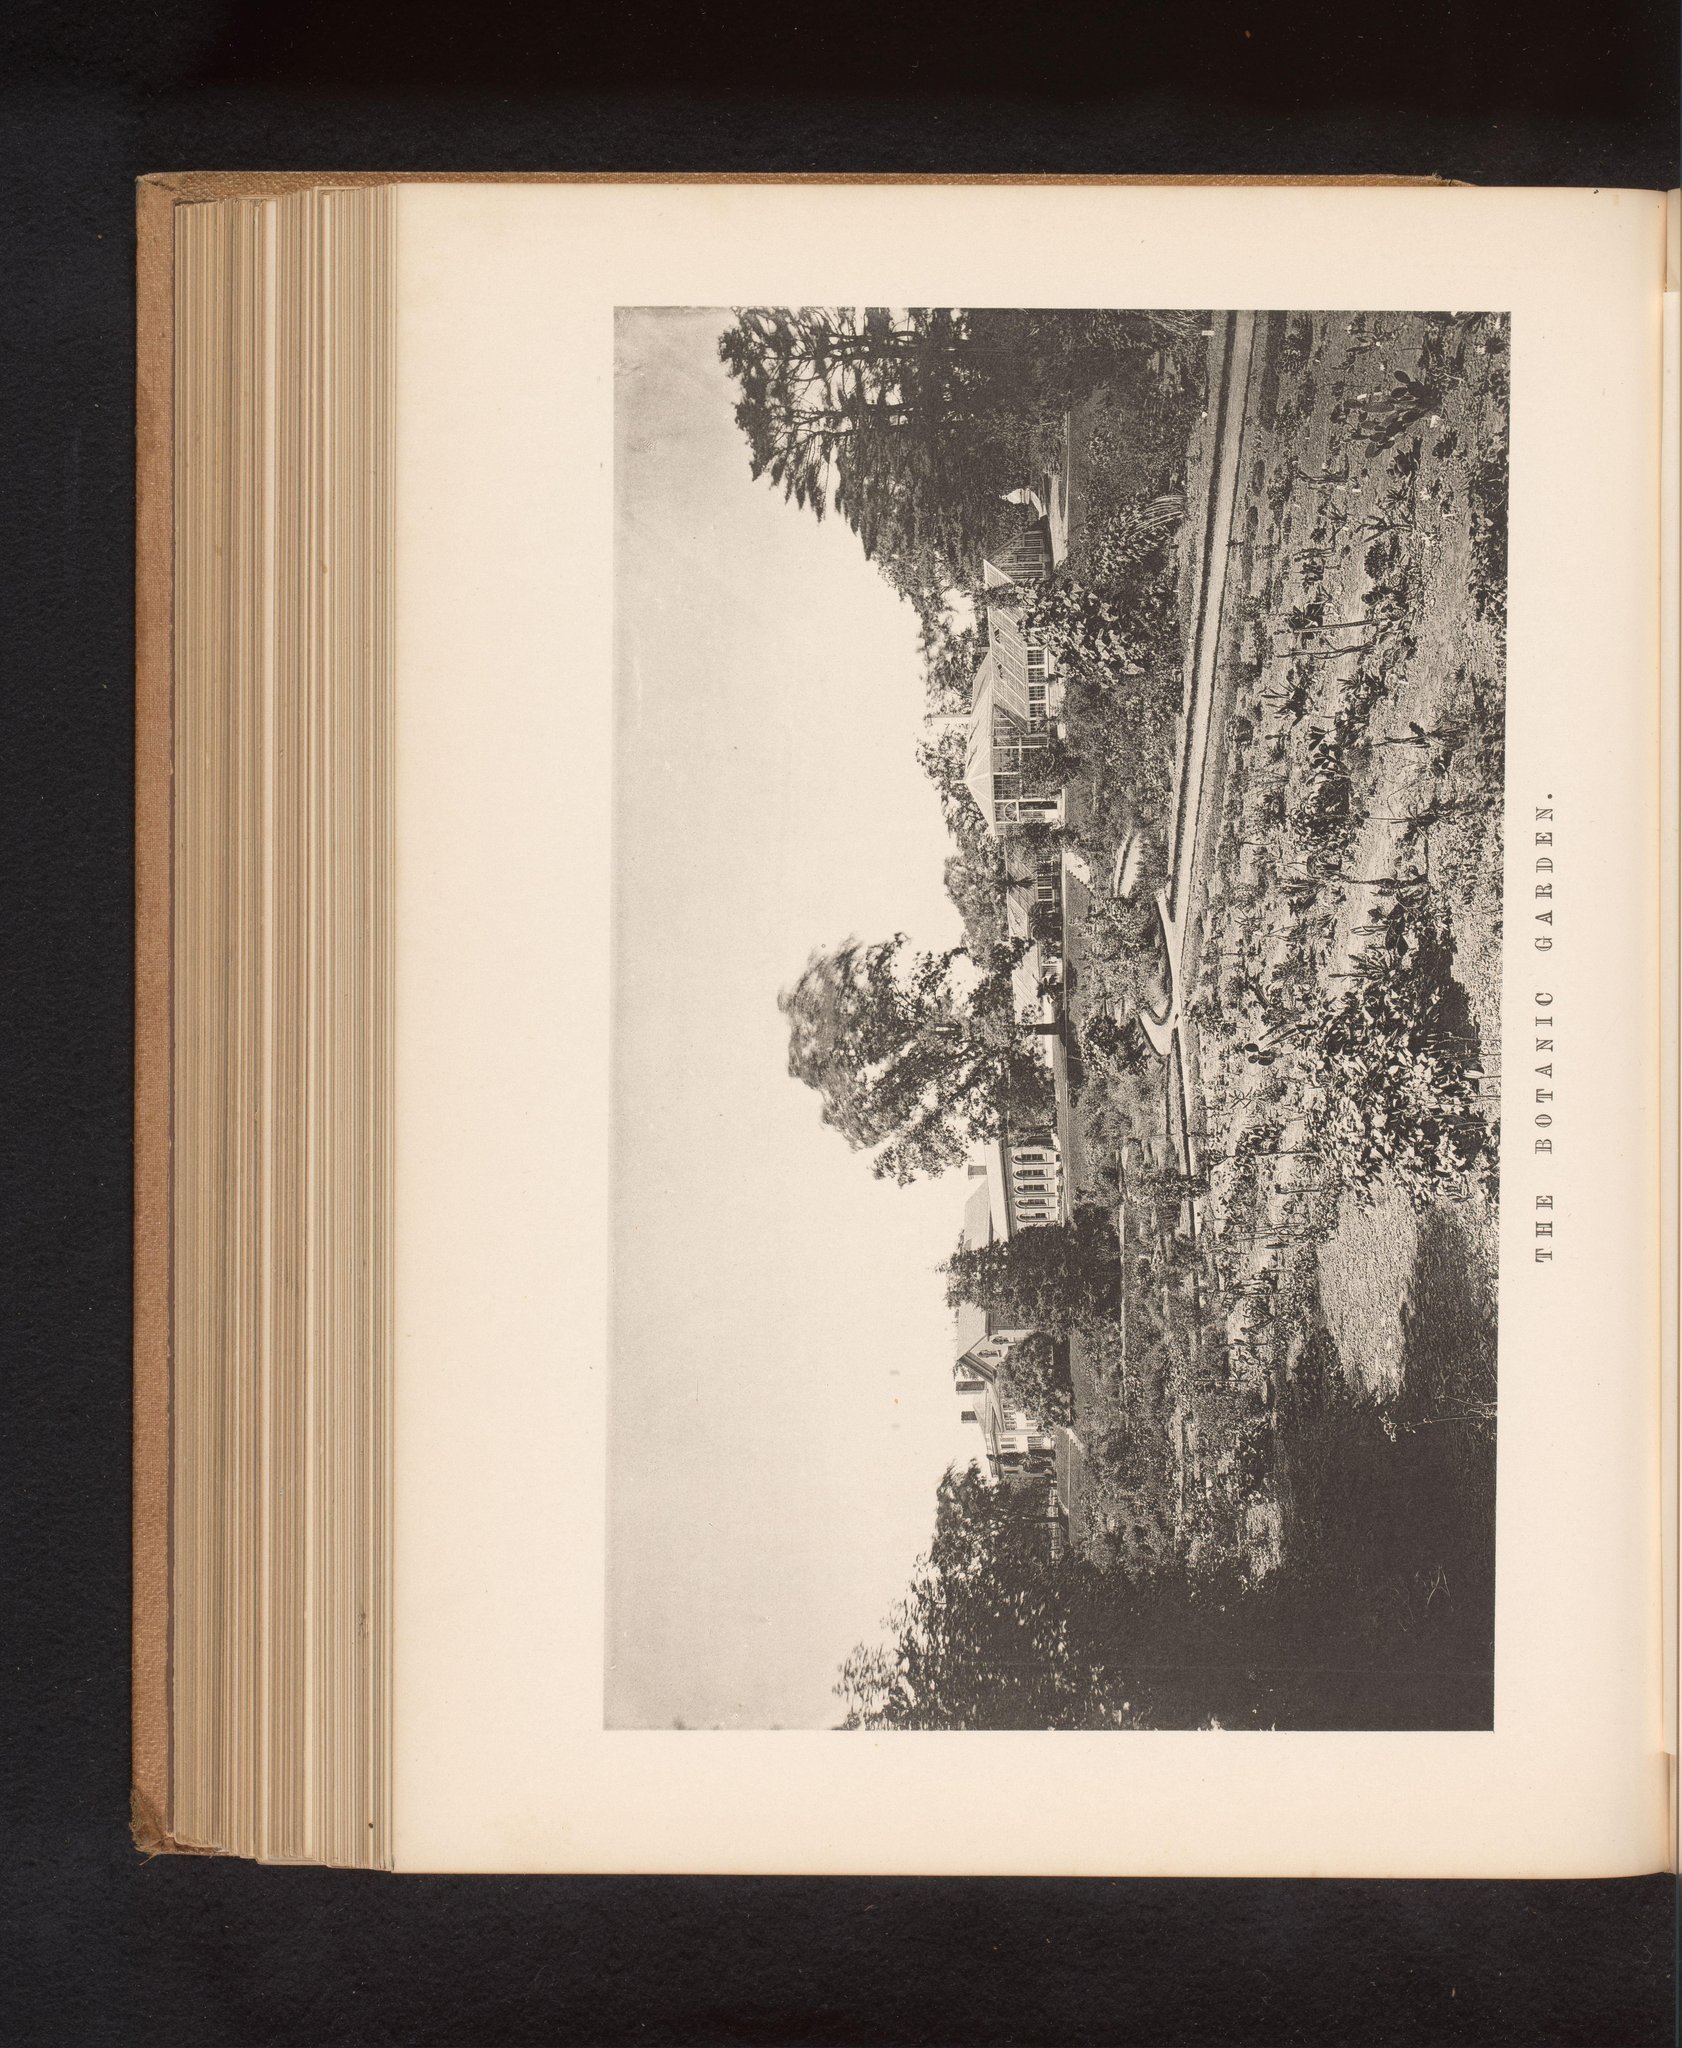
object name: photomechanical print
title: Gezicht op de botanische tuin van de Harvard-universiteit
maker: Anonymous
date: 1870-1875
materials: paper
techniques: photograph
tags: university building, college, botanic garden, 'hortus botanicus'